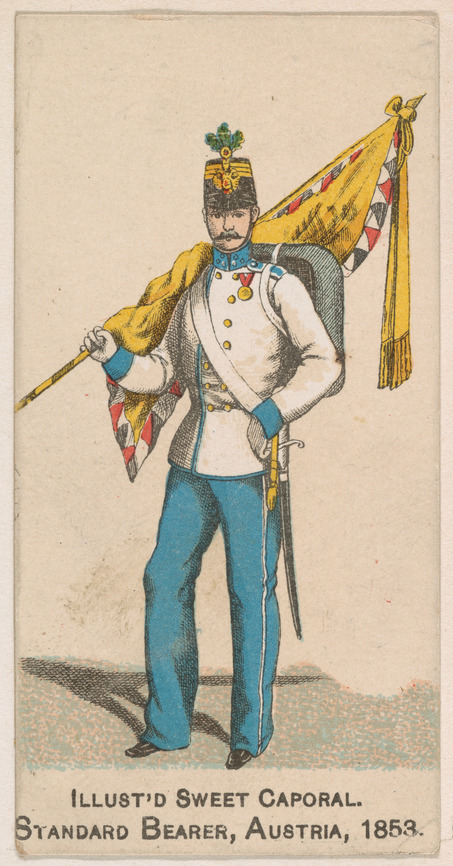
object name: print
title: Standard Bearer, Austria, 1853, from the Military Series (N224) issued by Kinney Tobacco Company to promote Sweet Caporal Cigarettes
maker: kinney brothers tobacco company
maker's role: publisher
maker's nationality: american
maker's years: 1869-2011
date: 1888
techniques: color lithograph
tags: military,men,flags